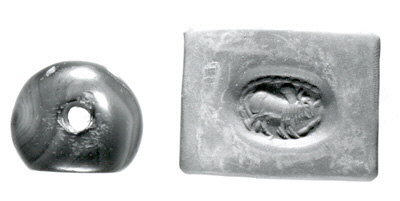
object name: stamp seal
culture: sasanian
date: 401-600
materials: stone, quartz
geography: iran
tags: animals